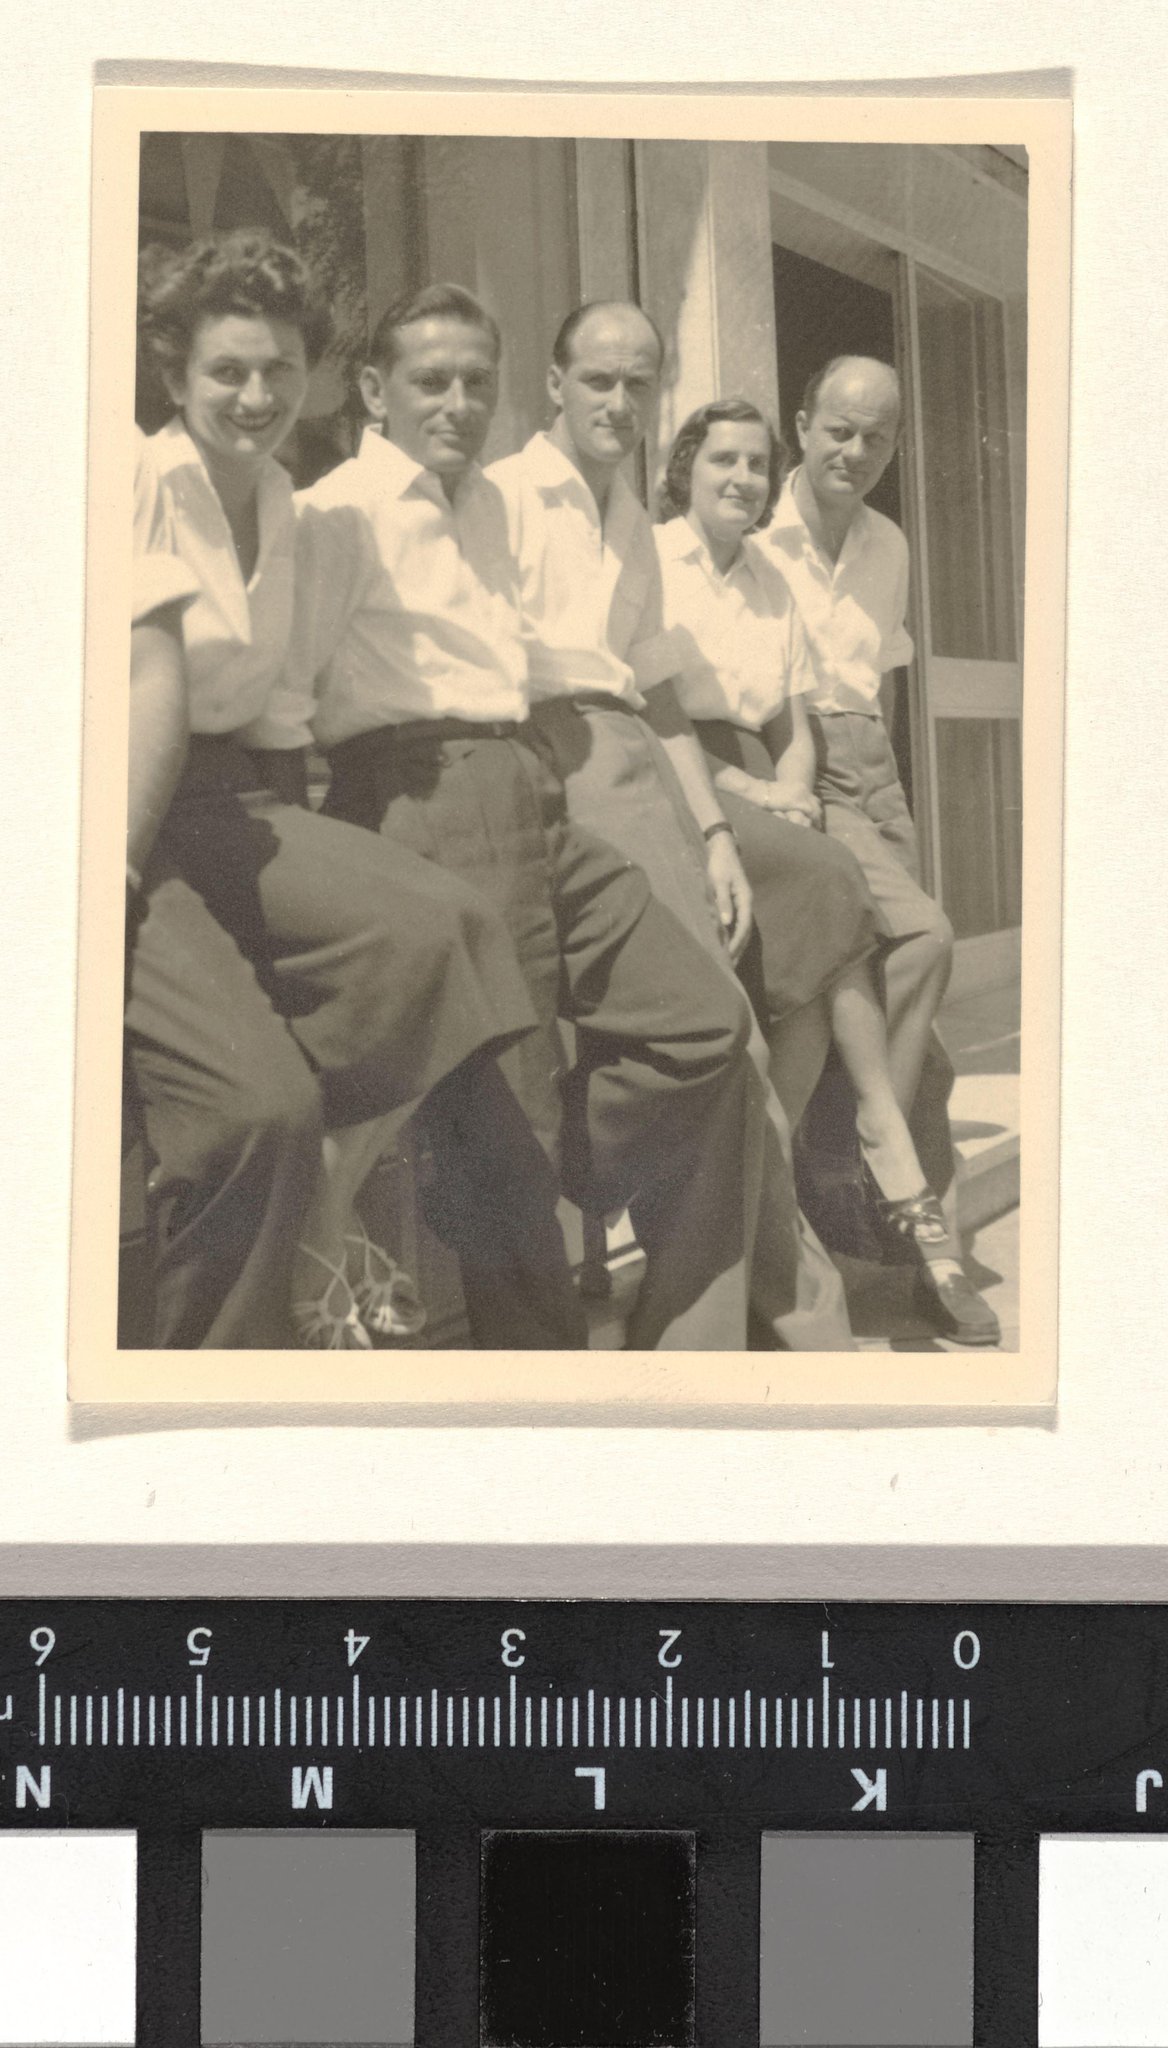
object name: photograph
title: Isabel Wachenheimer en haar derde echtgenoot Gideon Elon steunend tegen een reling gekleed in donkere broek en licht hemd, met drie onbekende mensen in dezelfde kleding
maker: Anonymous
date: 1947-1955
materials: photographic support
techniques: gelatin silver print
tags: leiden, isabel wachenheimer-elon, gideon elon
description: Isabel Wachenheimer (2e van rechts) en haar derde echtgenoot Gideon Elon (2e van links) steunend tegen een reling gekleed in donkere broek en licht hemd, met drie onbekende mensen in dezelfde kleding